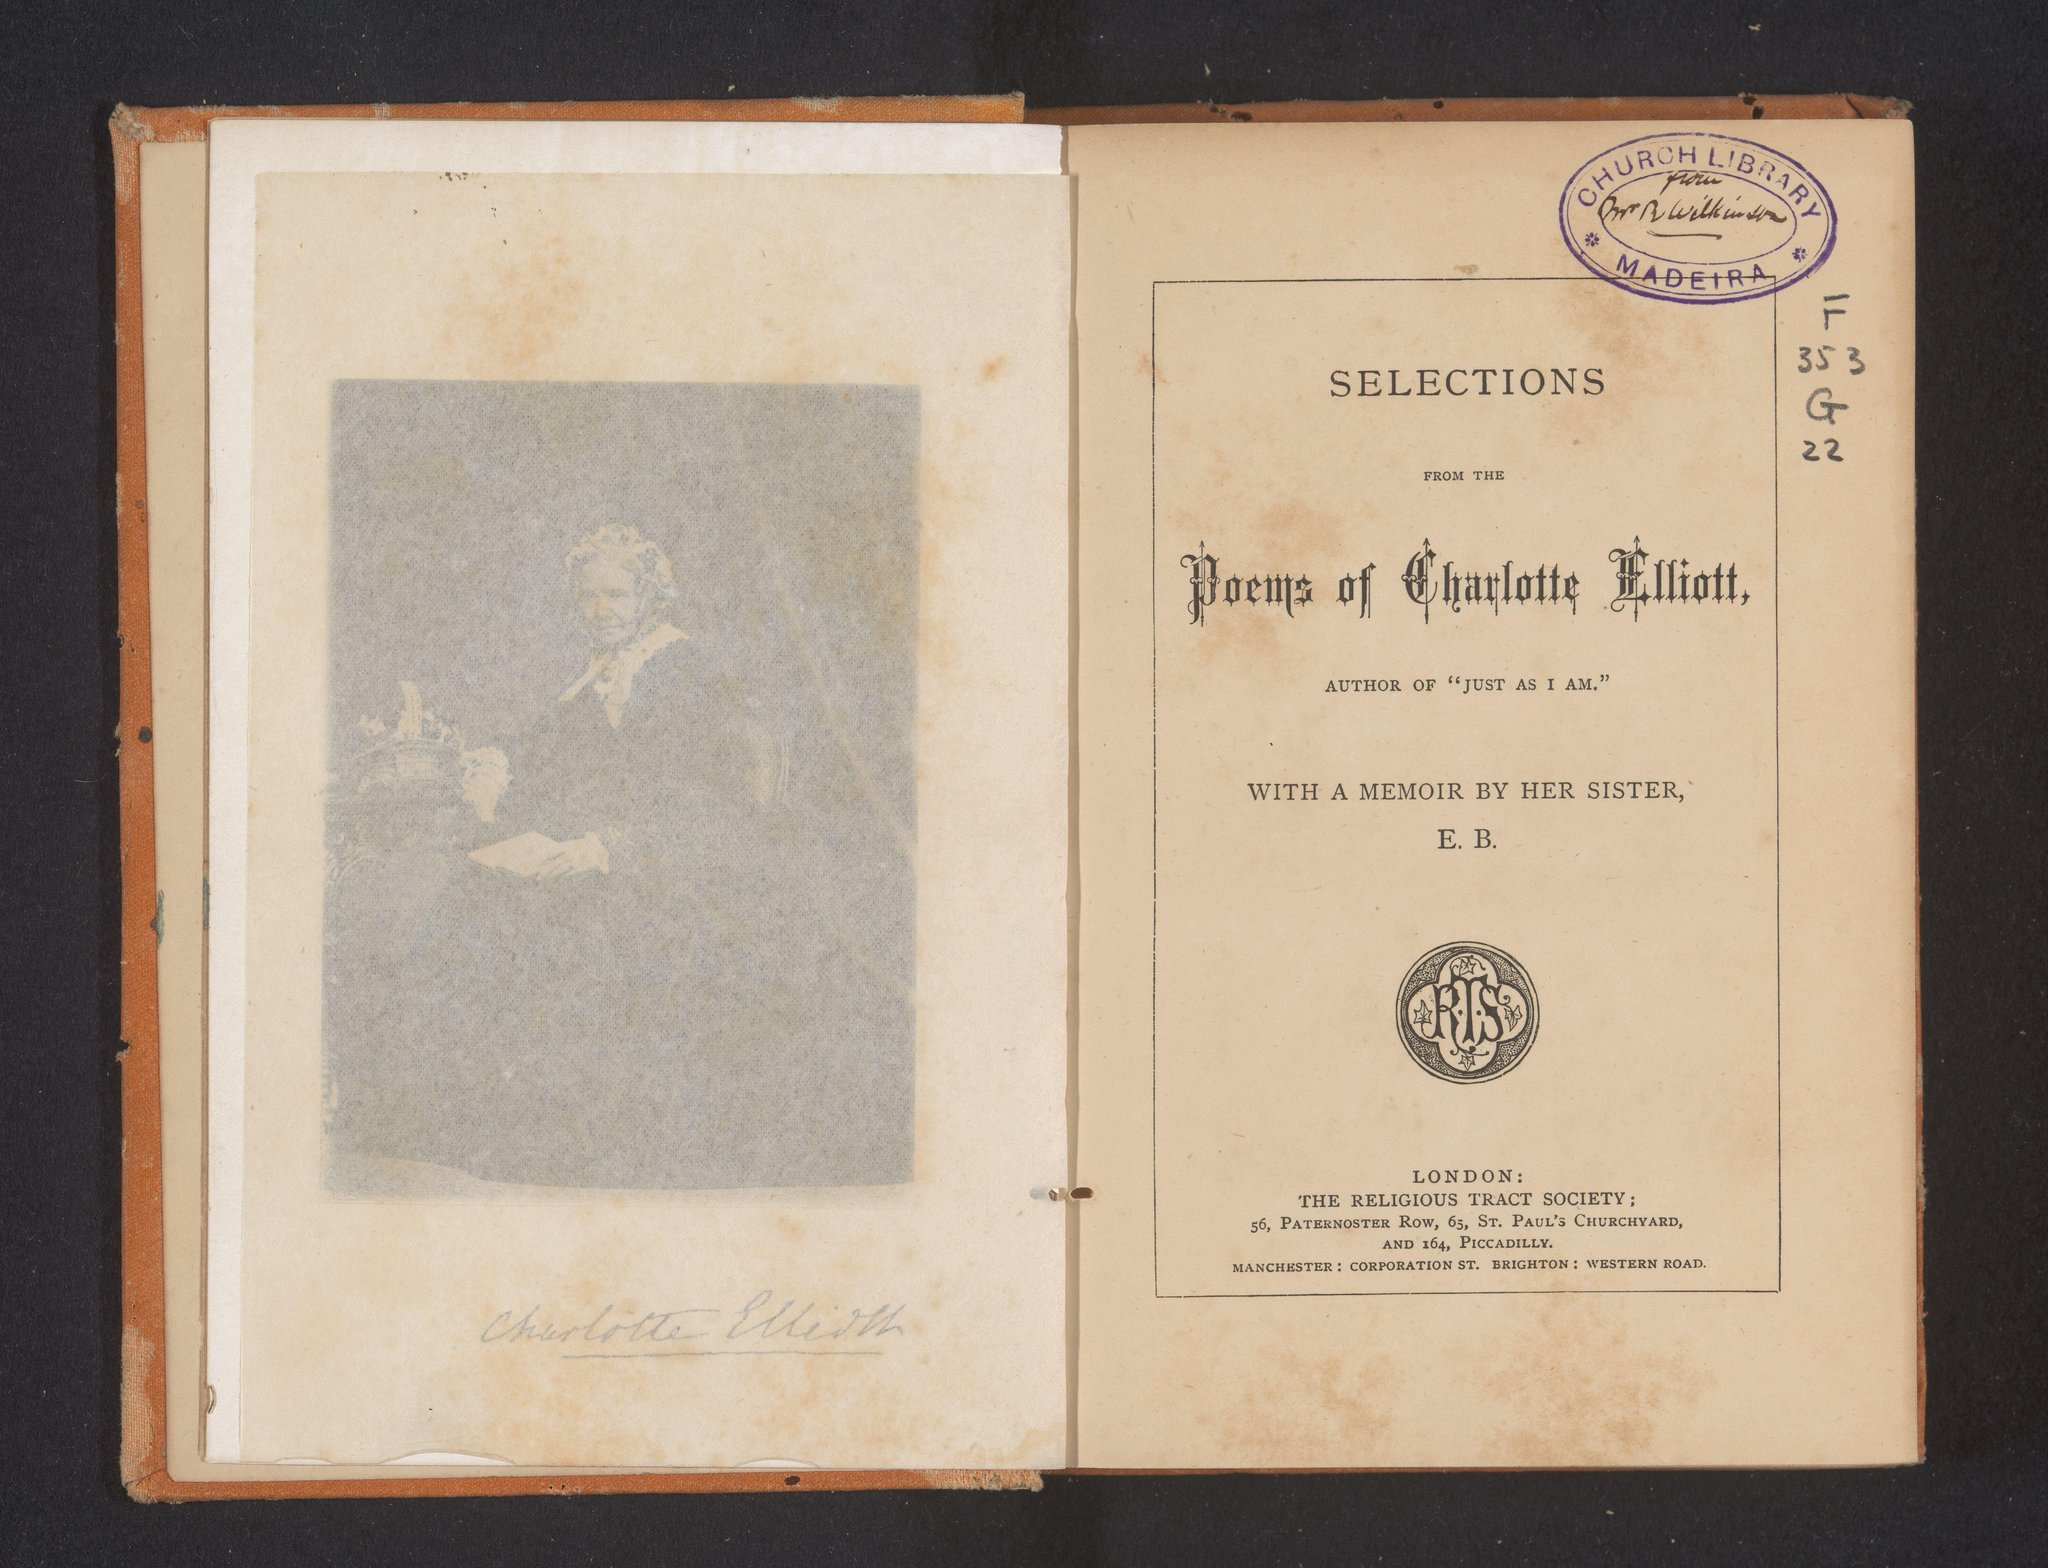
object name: book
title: Selections from the poems of Charlotte Elliott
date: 1873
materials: linen, paper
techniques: photograph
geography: london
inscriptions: name: ‘ex libris SFJ’, name: ‘Church Library Madeira’